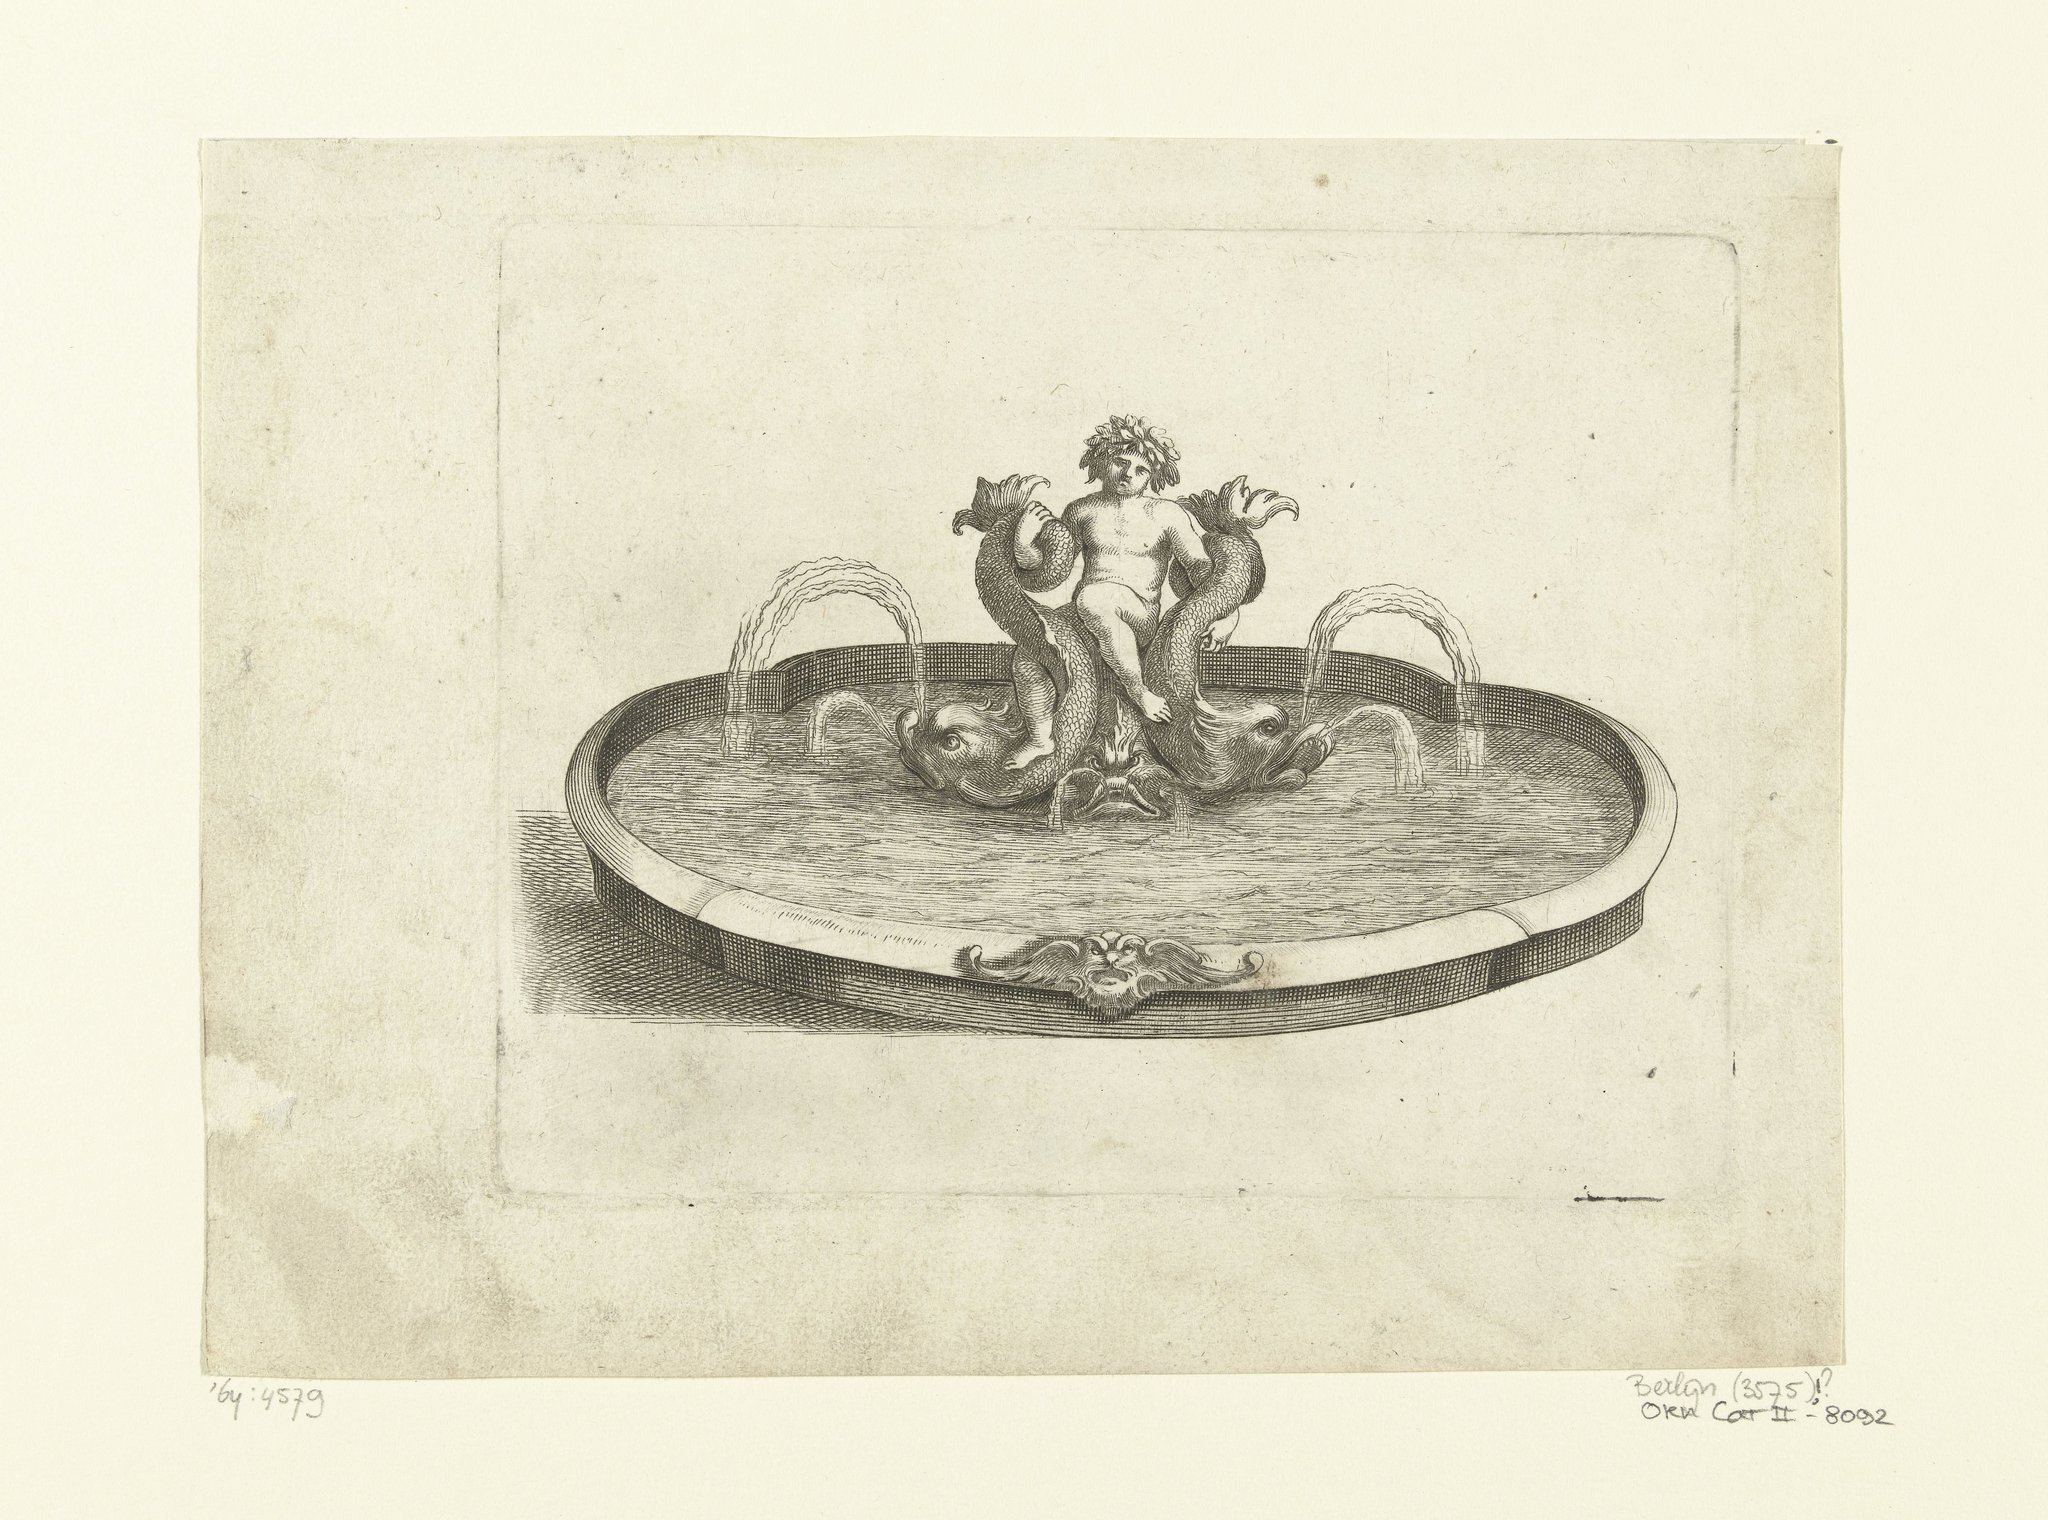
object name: print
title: Fontein met putto zittend op drie dolfijnen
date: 1680-1707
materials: paper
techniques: engraving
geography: paris